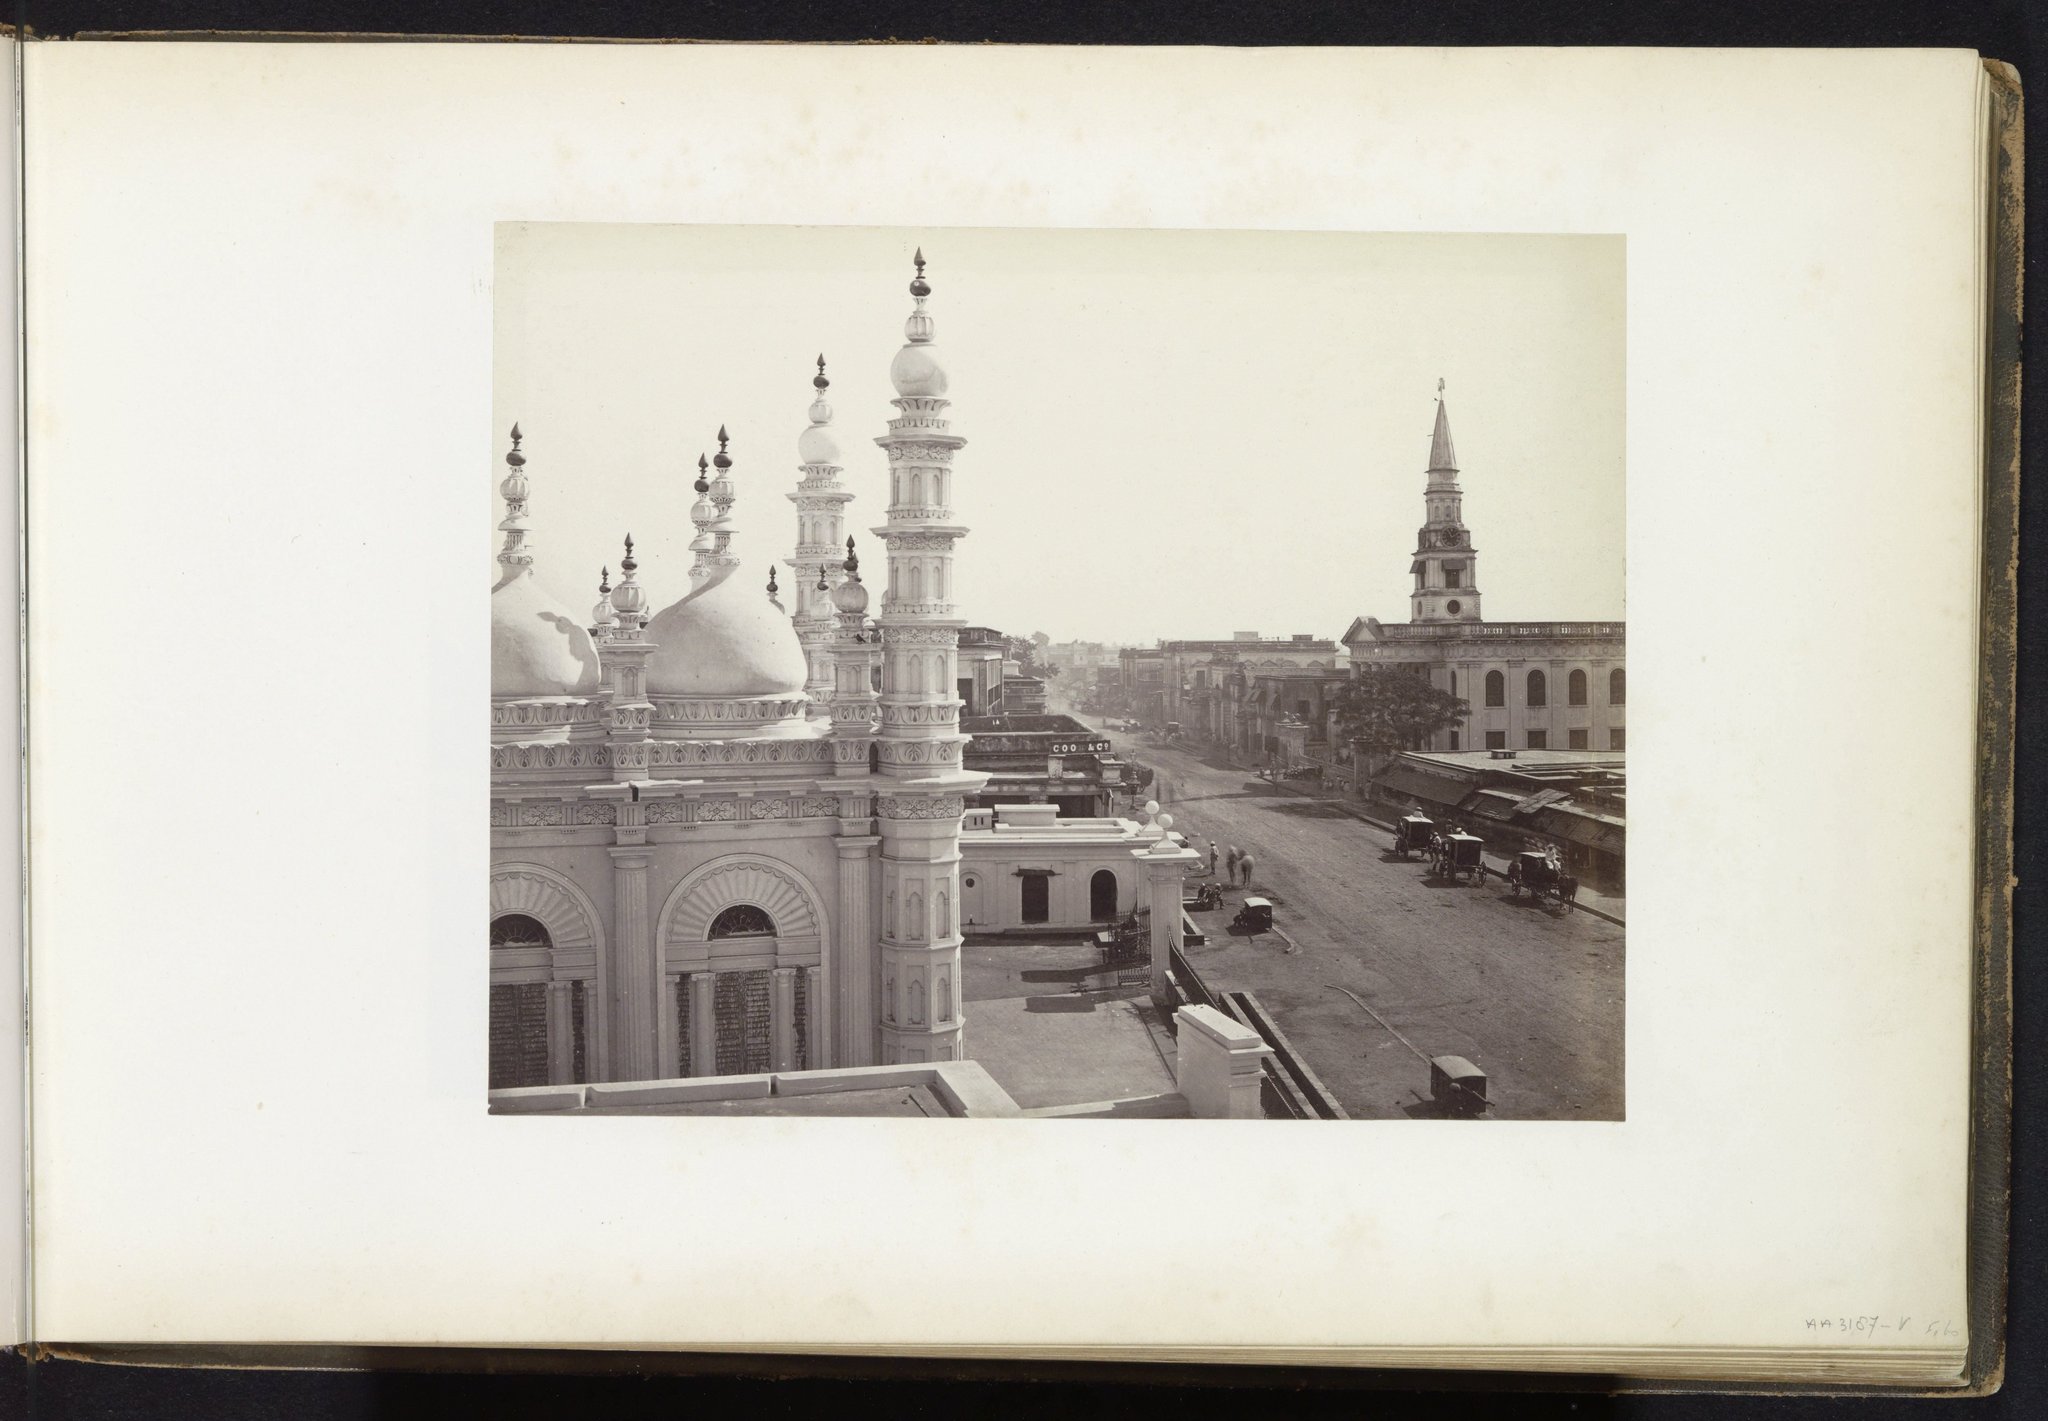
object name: photograph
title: Dharamtala street with the Tipu Sultan Shahi mosque and the Roman Catholic Sacred Heart Church at right, Kolkata, West Bengal, India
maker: Anonymous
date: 1865-1875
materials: photographic support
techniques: albumen print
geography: kolkata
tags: church (exterior), temple, shrine ~ islam, mohammedanism, street (+ city(-scape) with figures, staffage)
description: Onderdeel van Reisalbum met opnames van bezienswaardigheden in India, Duitsland, Zwitserland en Frankrijk.